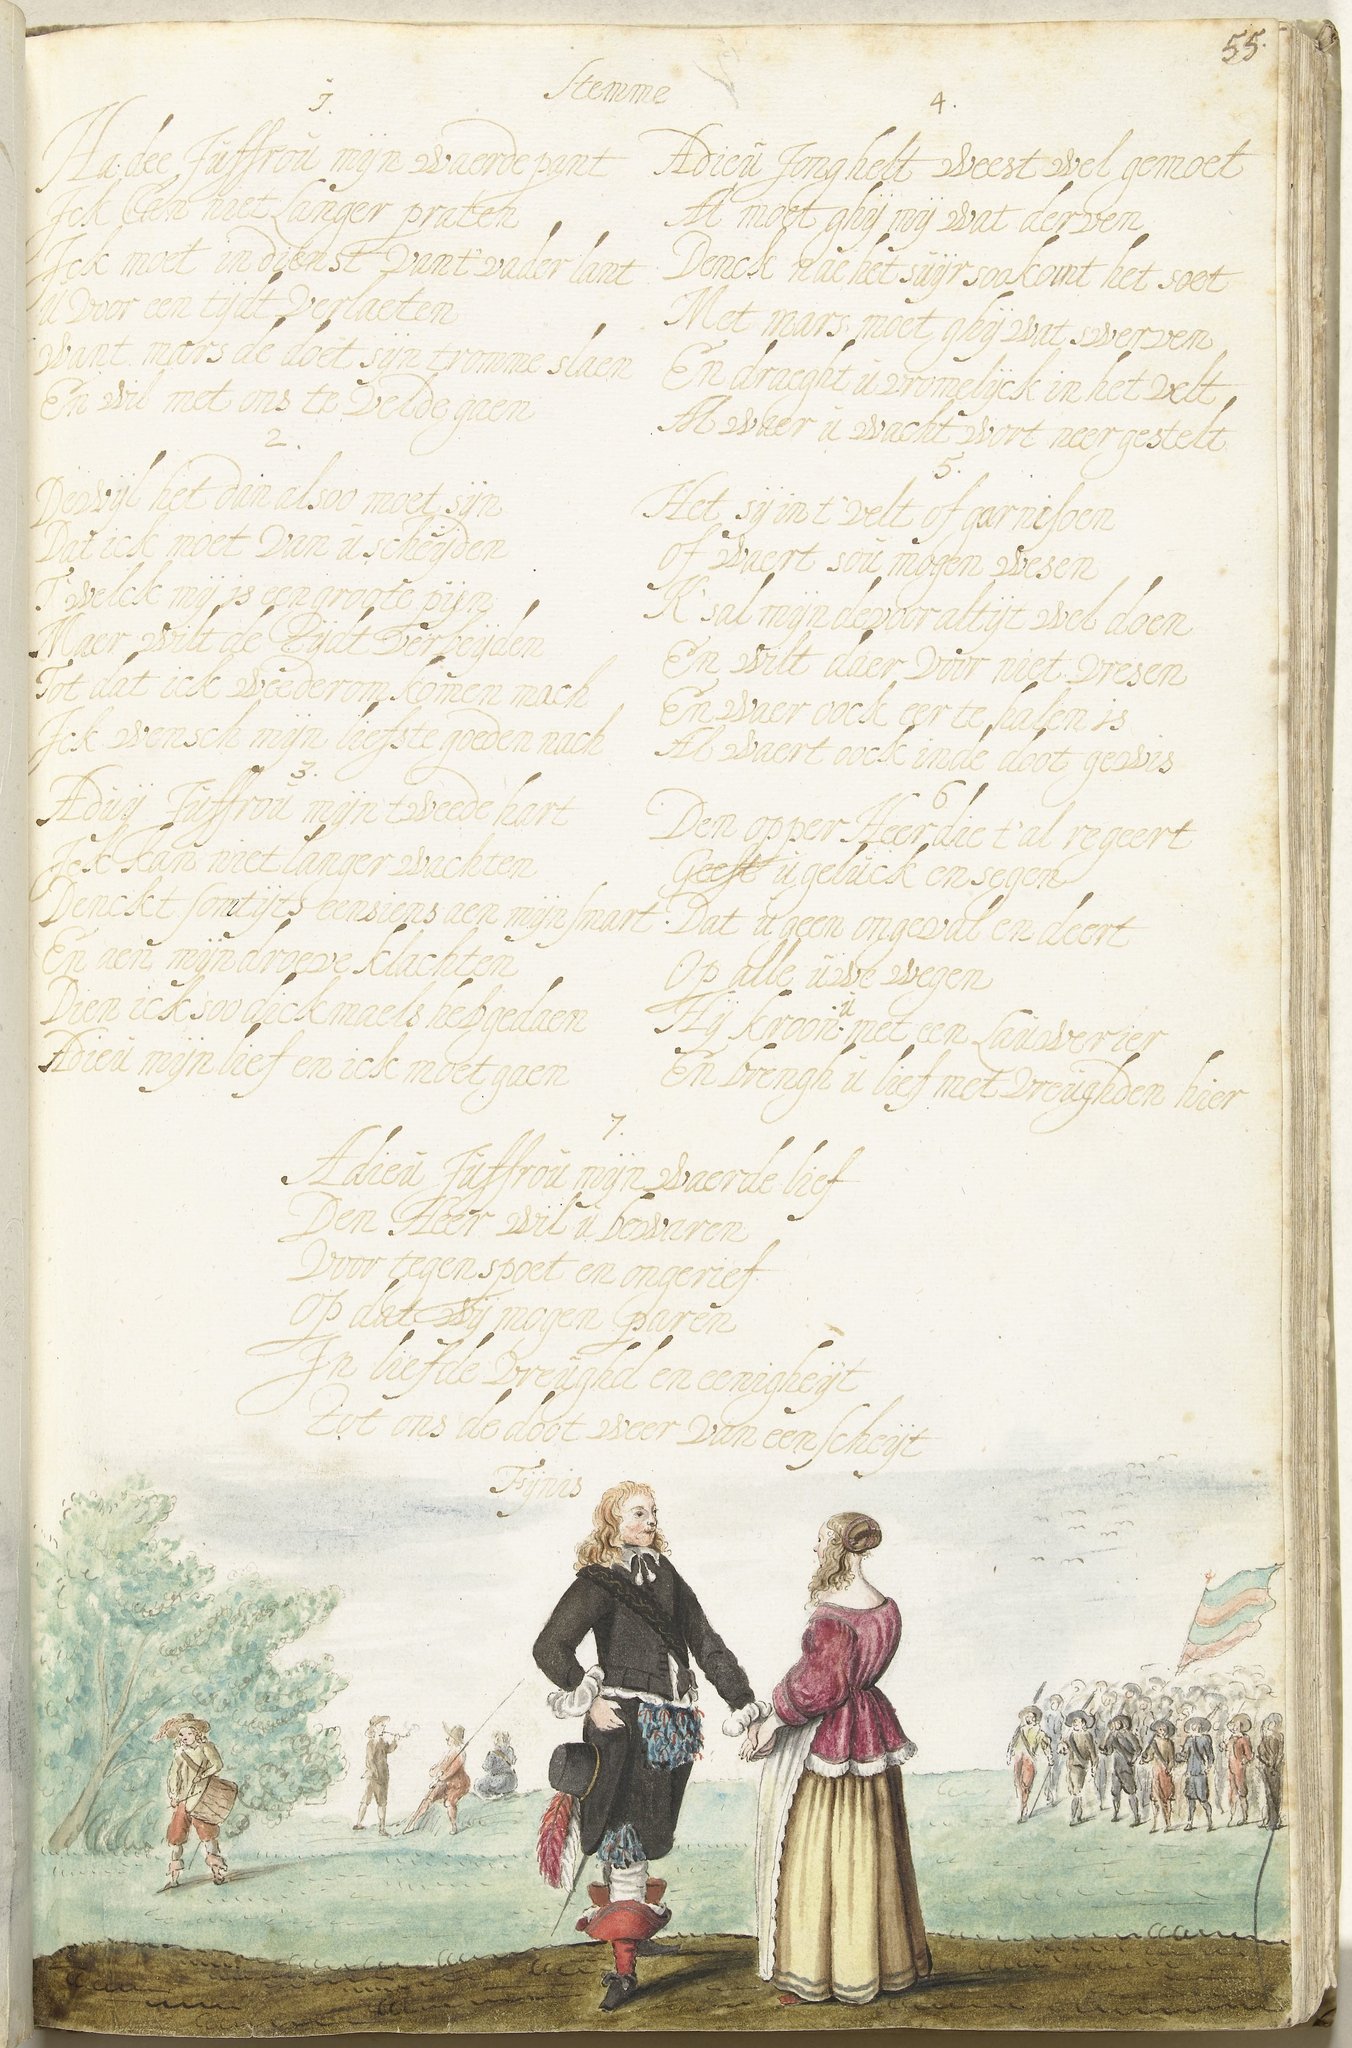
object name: poem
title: Officier die afscheid neemt van een dame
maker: gesina ter borch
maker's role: draughtsman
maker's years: 1633-1690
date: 1654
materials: ink, paper, watercolor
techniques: brush, calligraphy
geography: zwolle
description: Officier die afscheid neemt van een dame naast gedicht in de vorm van een militaire variant op de normaal gesproken amoreuze klacht, zonder aangegeven melodie. Het gedicht heeft de vorm van een afscheidslied in de oude traditie van de middeleeuwse afscheidsliederen.